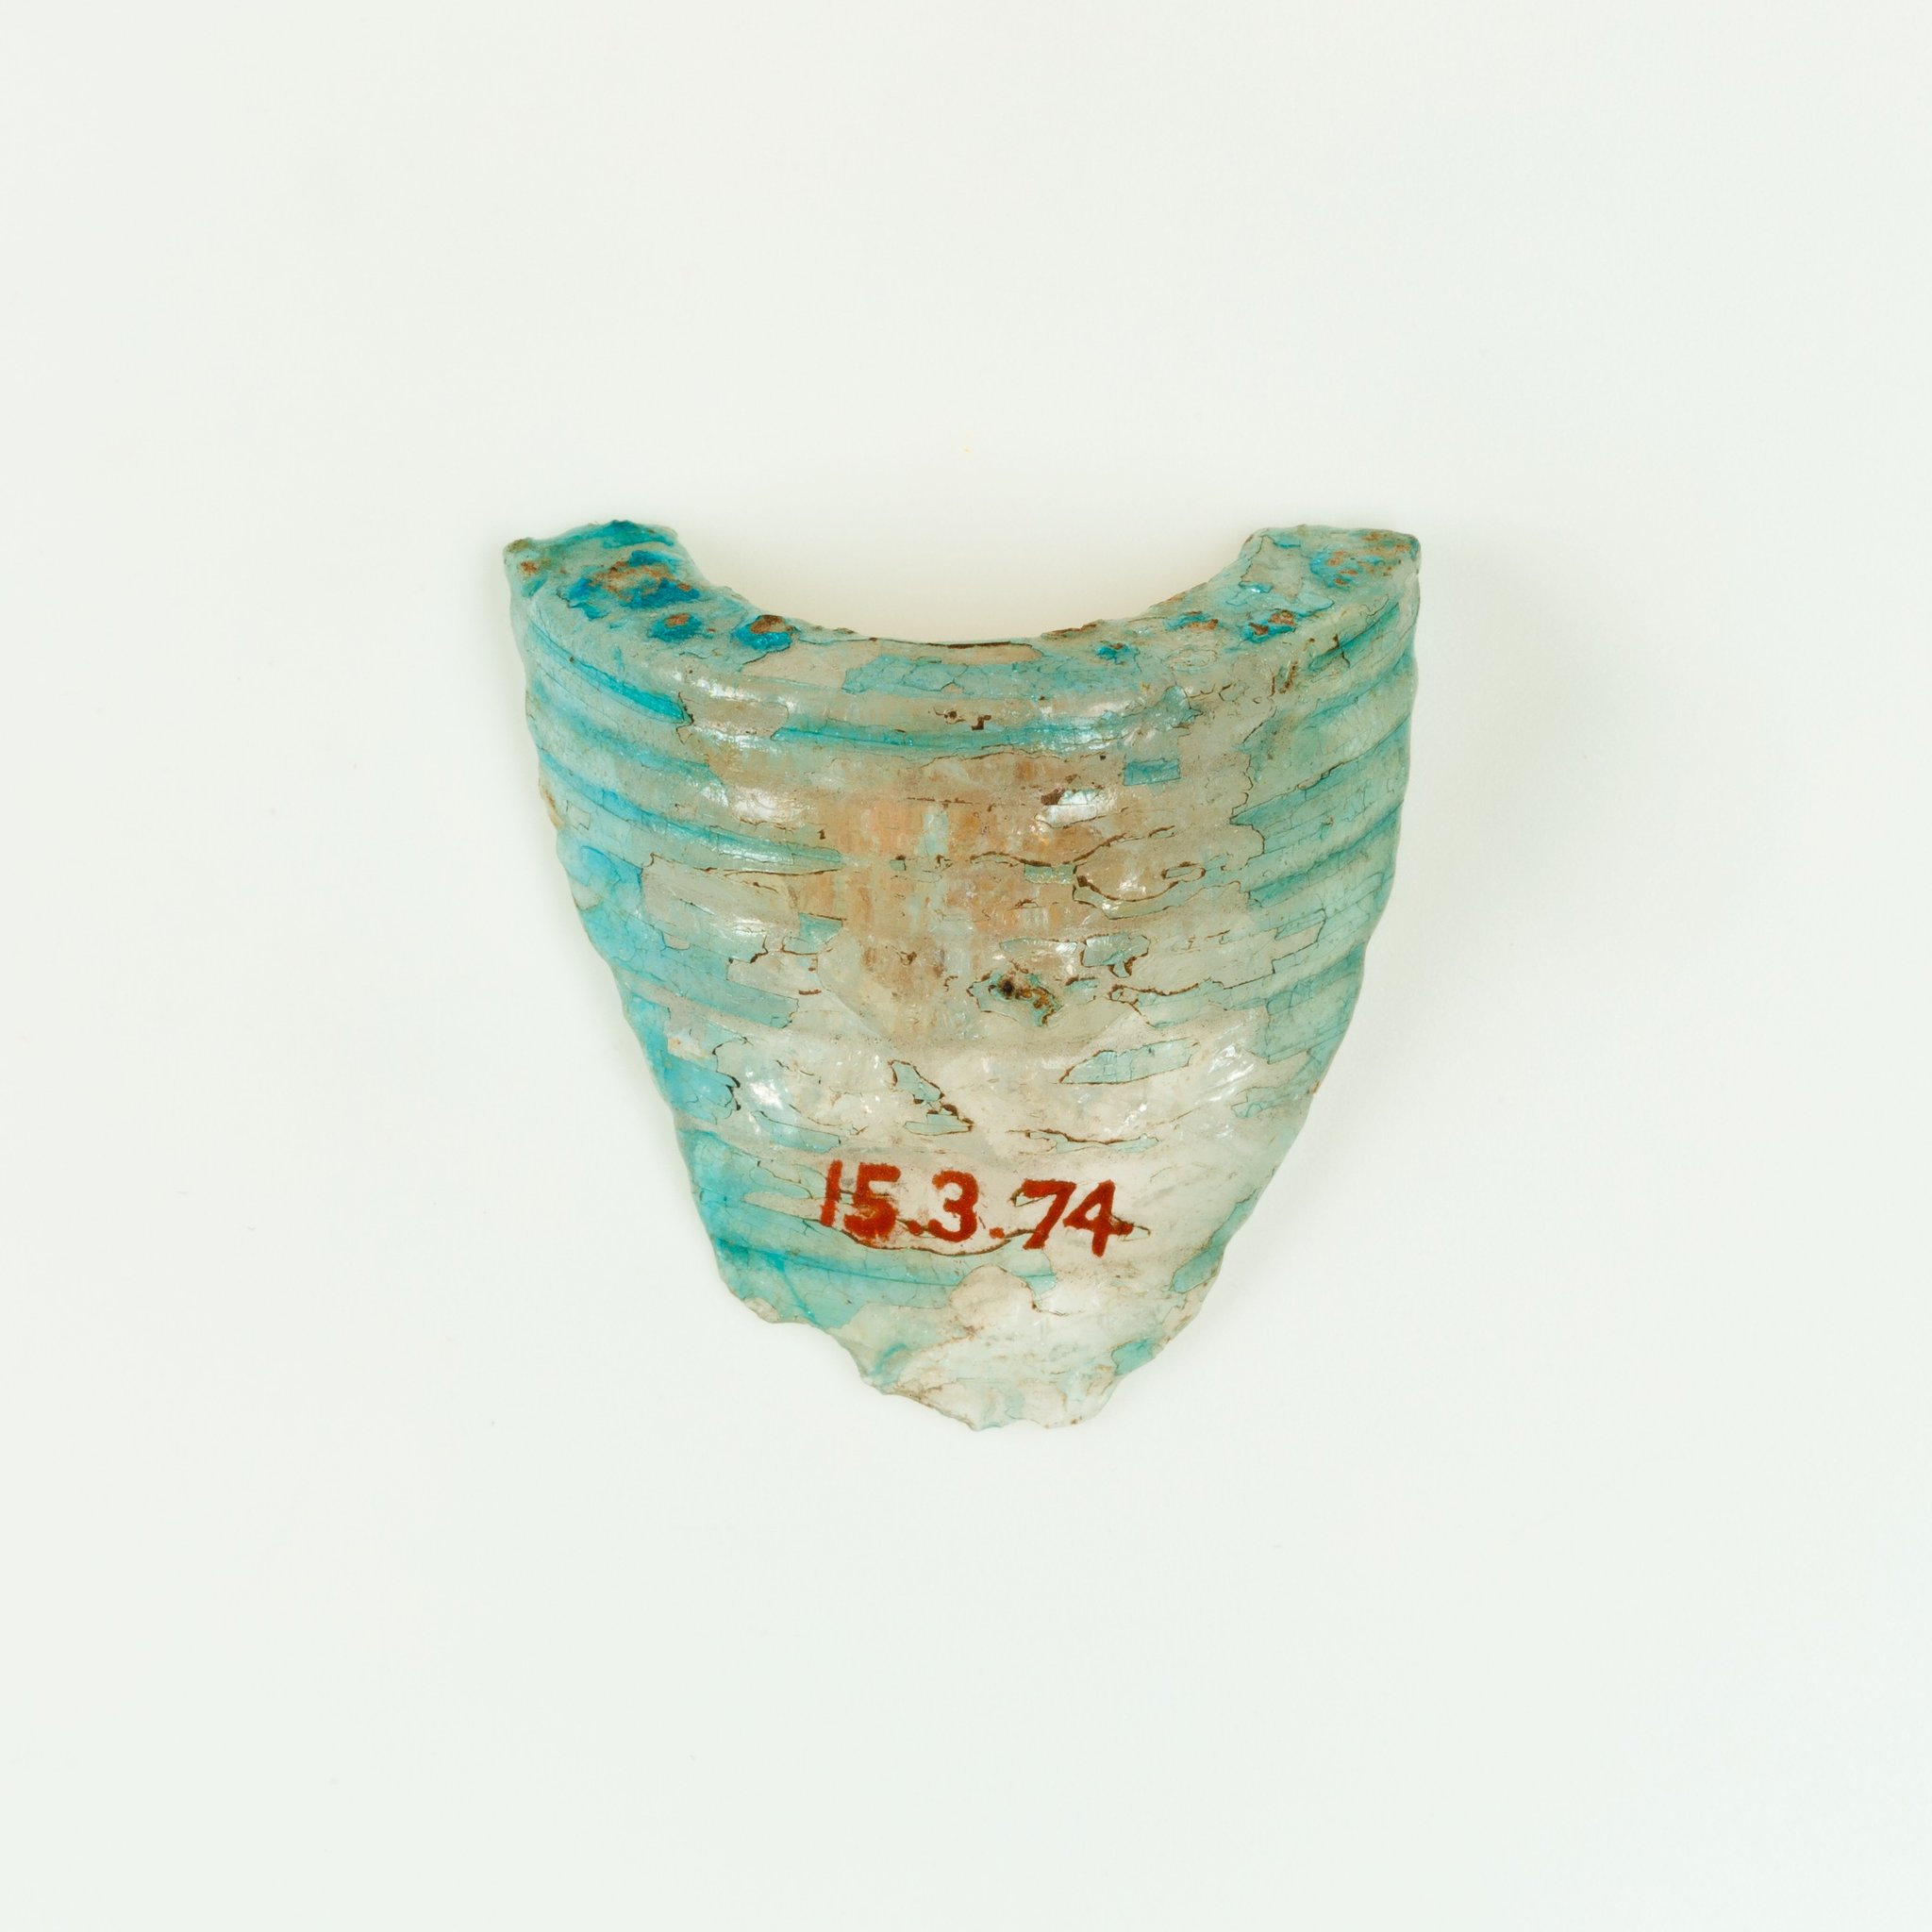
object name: vase fragment, 3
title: Fragment of vase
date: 1850-1640 BCE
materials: glaze, quartz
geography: egypt